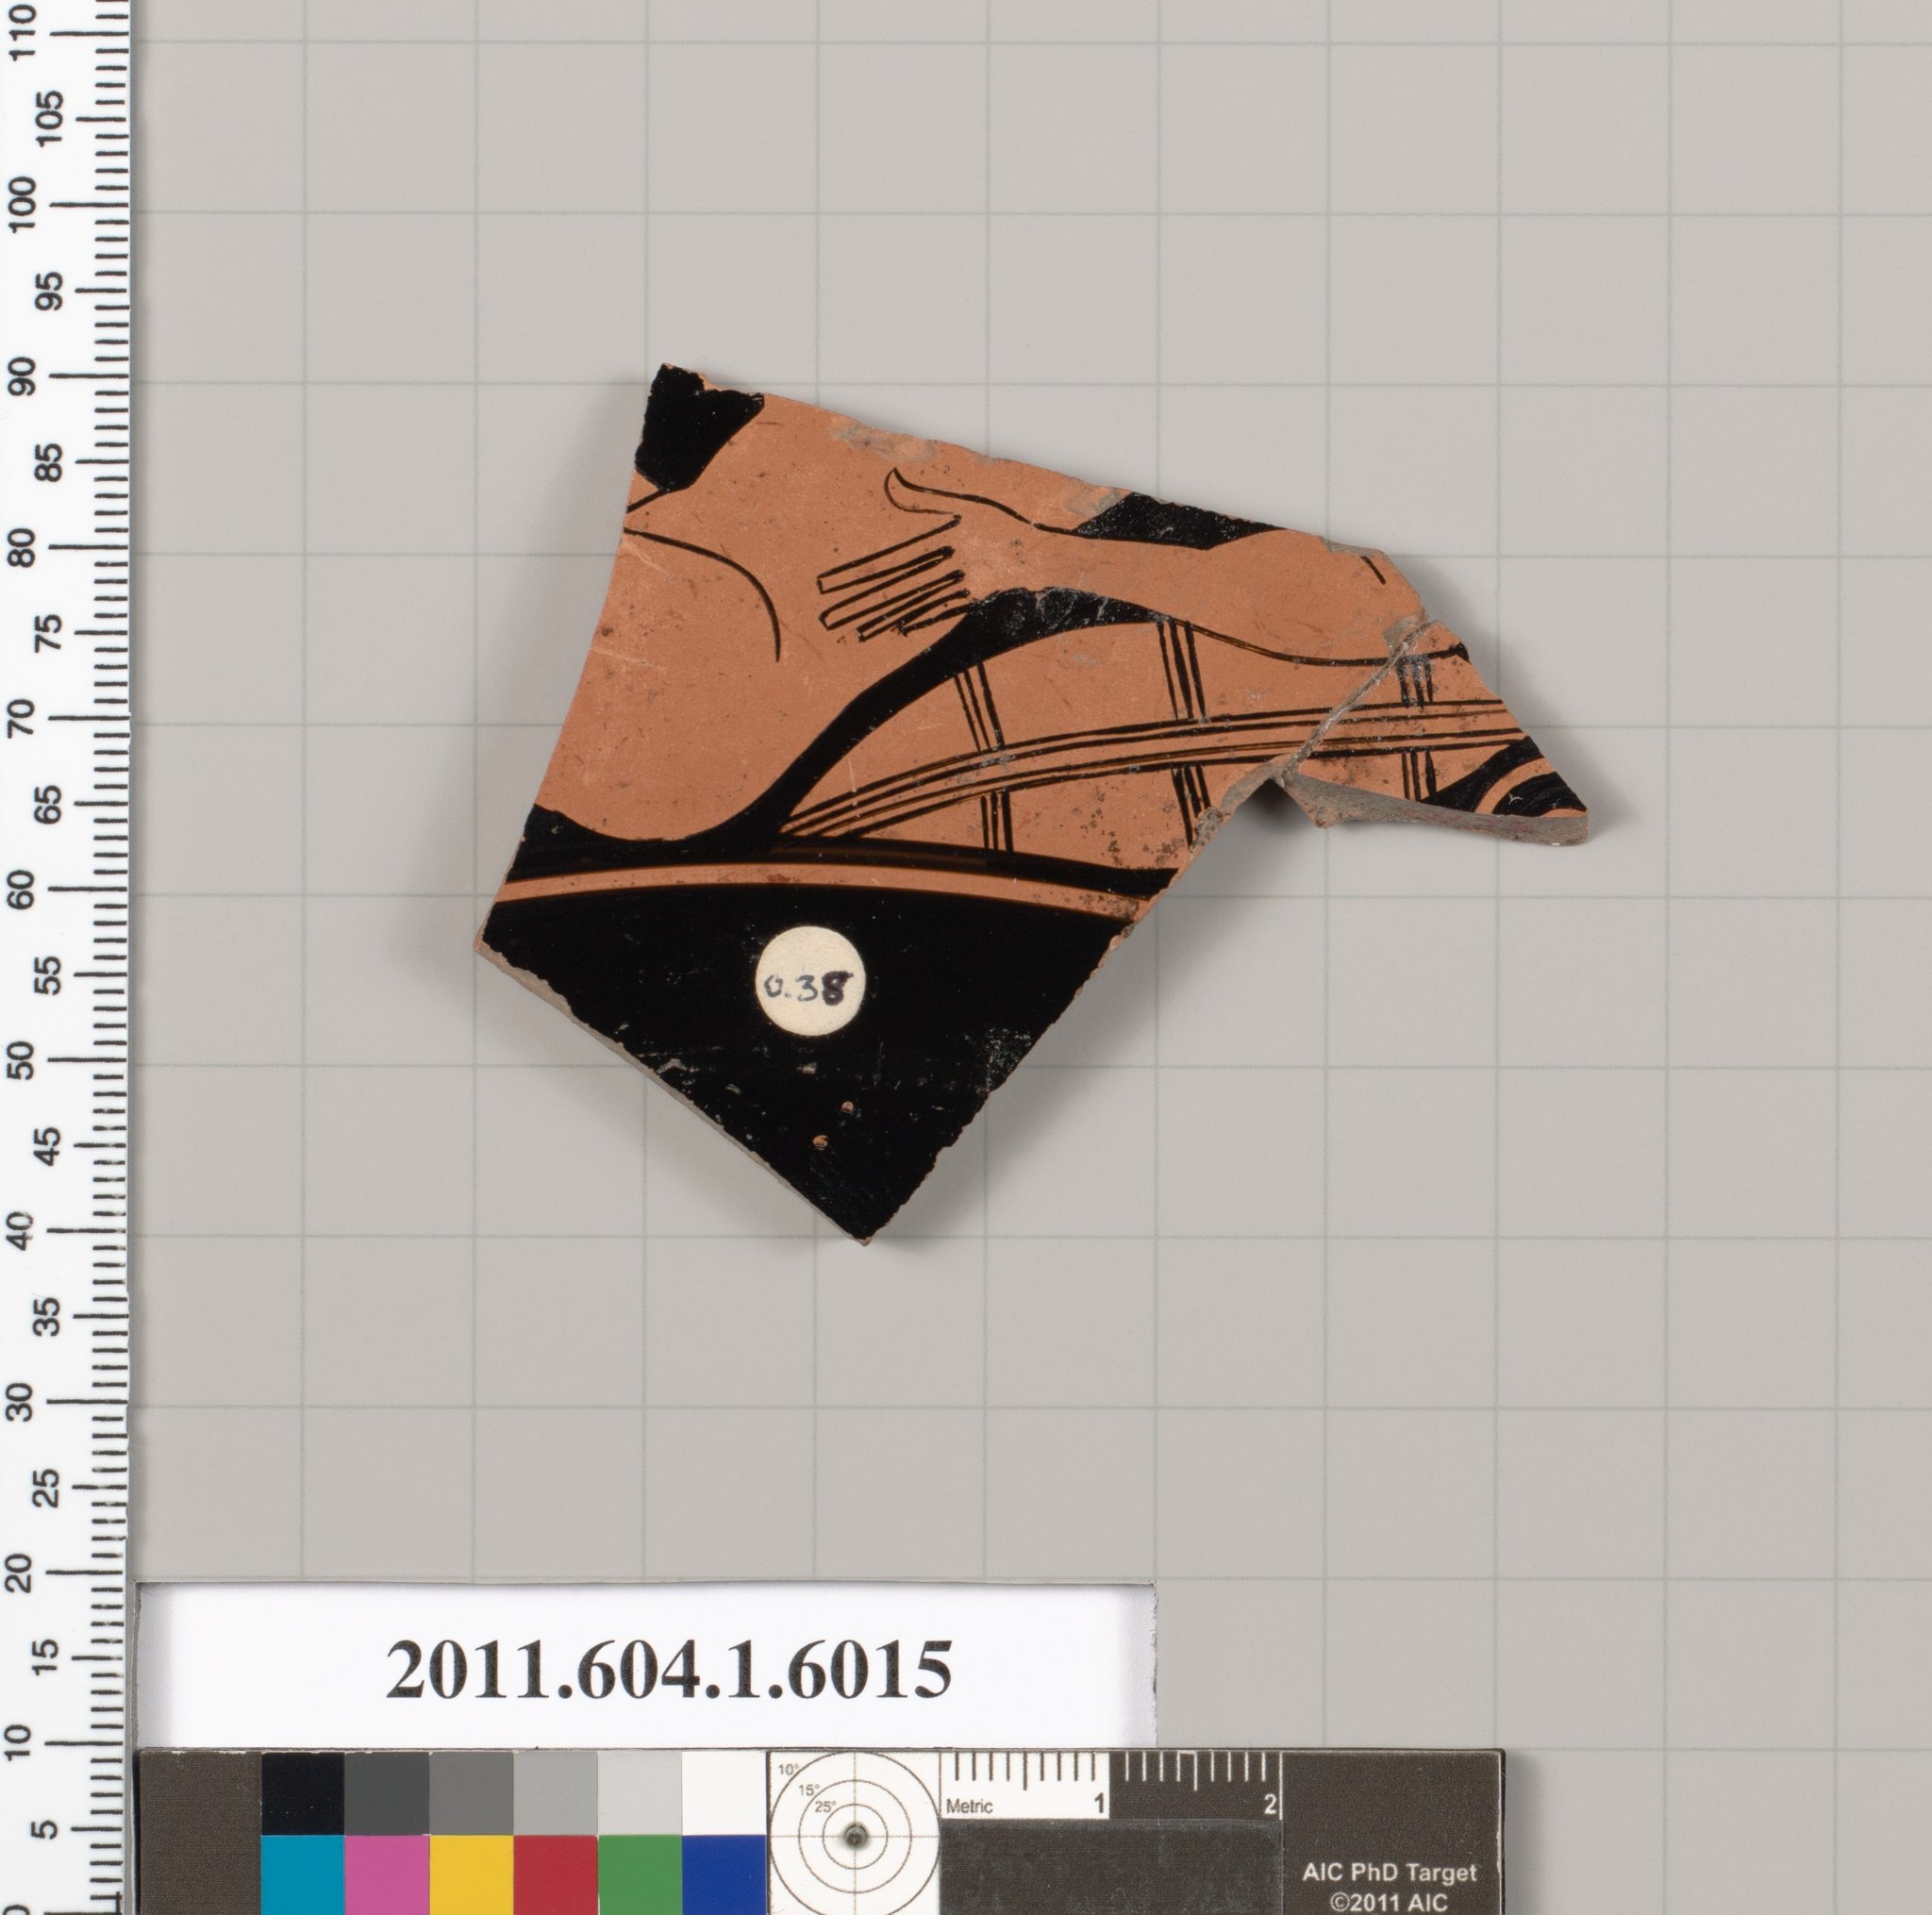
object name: kylix fragment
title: Terracotta fragment of a kylix (drinking cup)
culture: greek, attic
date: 510-500 BCE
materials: terracotta